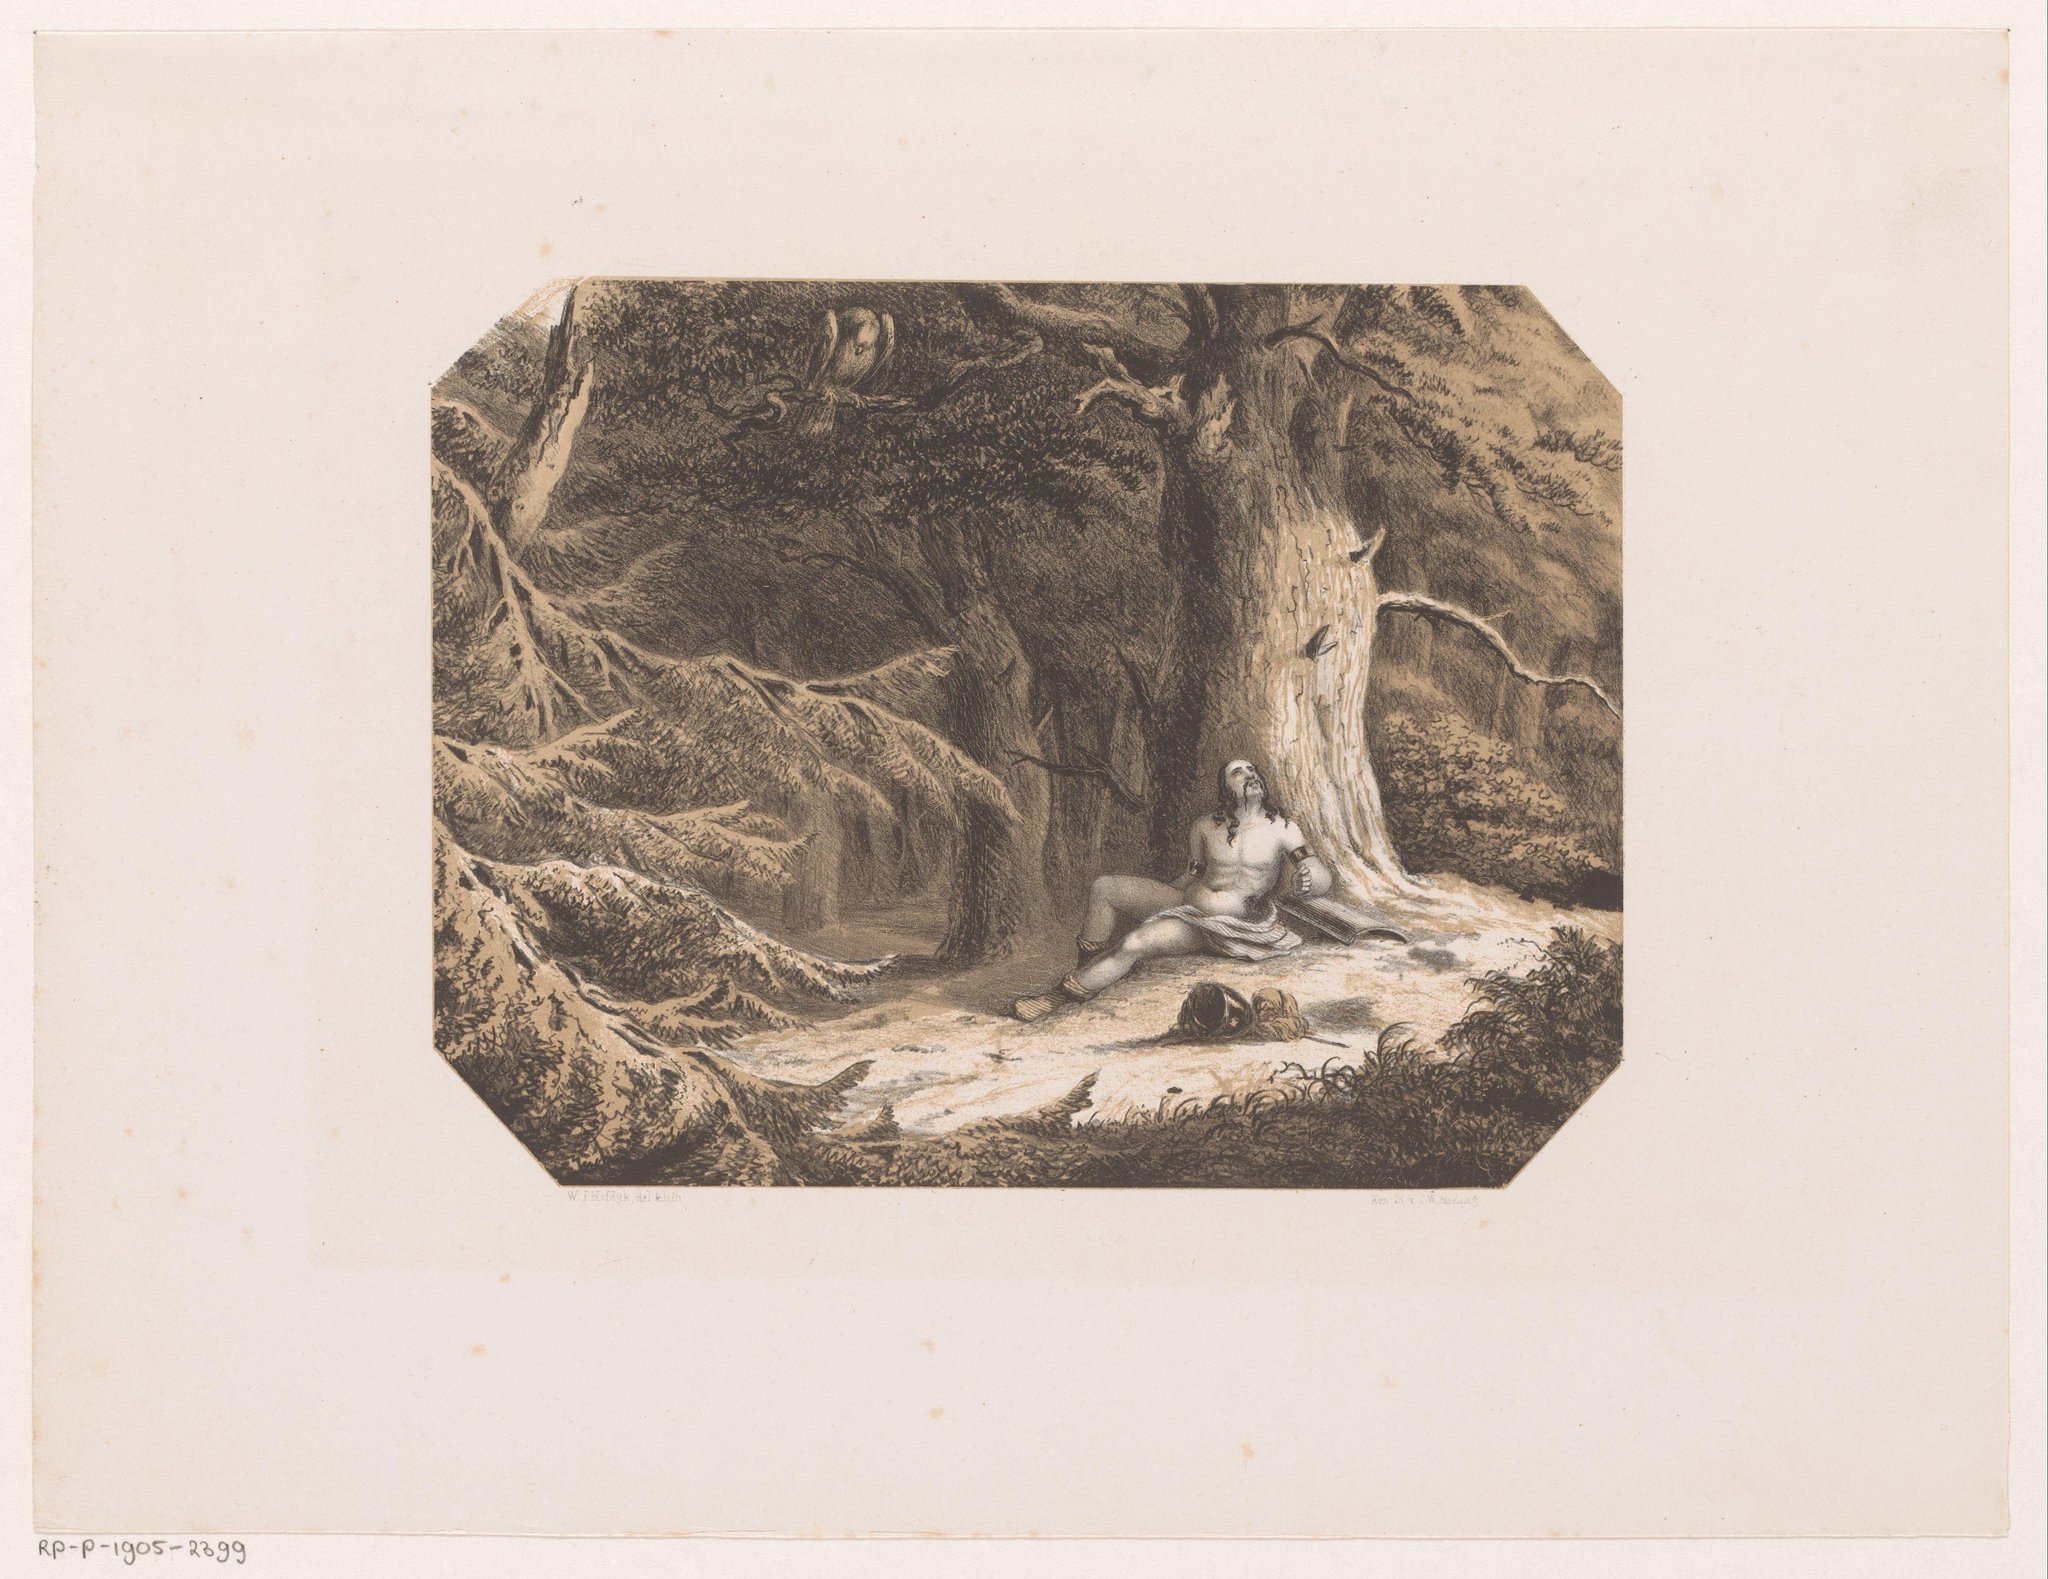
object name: print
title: Half ontklede man in het bos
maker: willem jacob hofdijk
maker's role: painter, print maker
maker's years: 1816-1888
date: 1847-1863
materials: paper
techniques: tone lithography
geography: netherlands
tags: infections and wounds (+ lying), extinct, 'historical' peoples: teutons, forest, wood, predatory birds: vulture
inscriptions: collector's mark: Lugt 2228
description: De man kijkt omhoog, hij is gewond in zijn zij. Mogelijk een Germaan. Linksboven hem zit een gier op een tak.